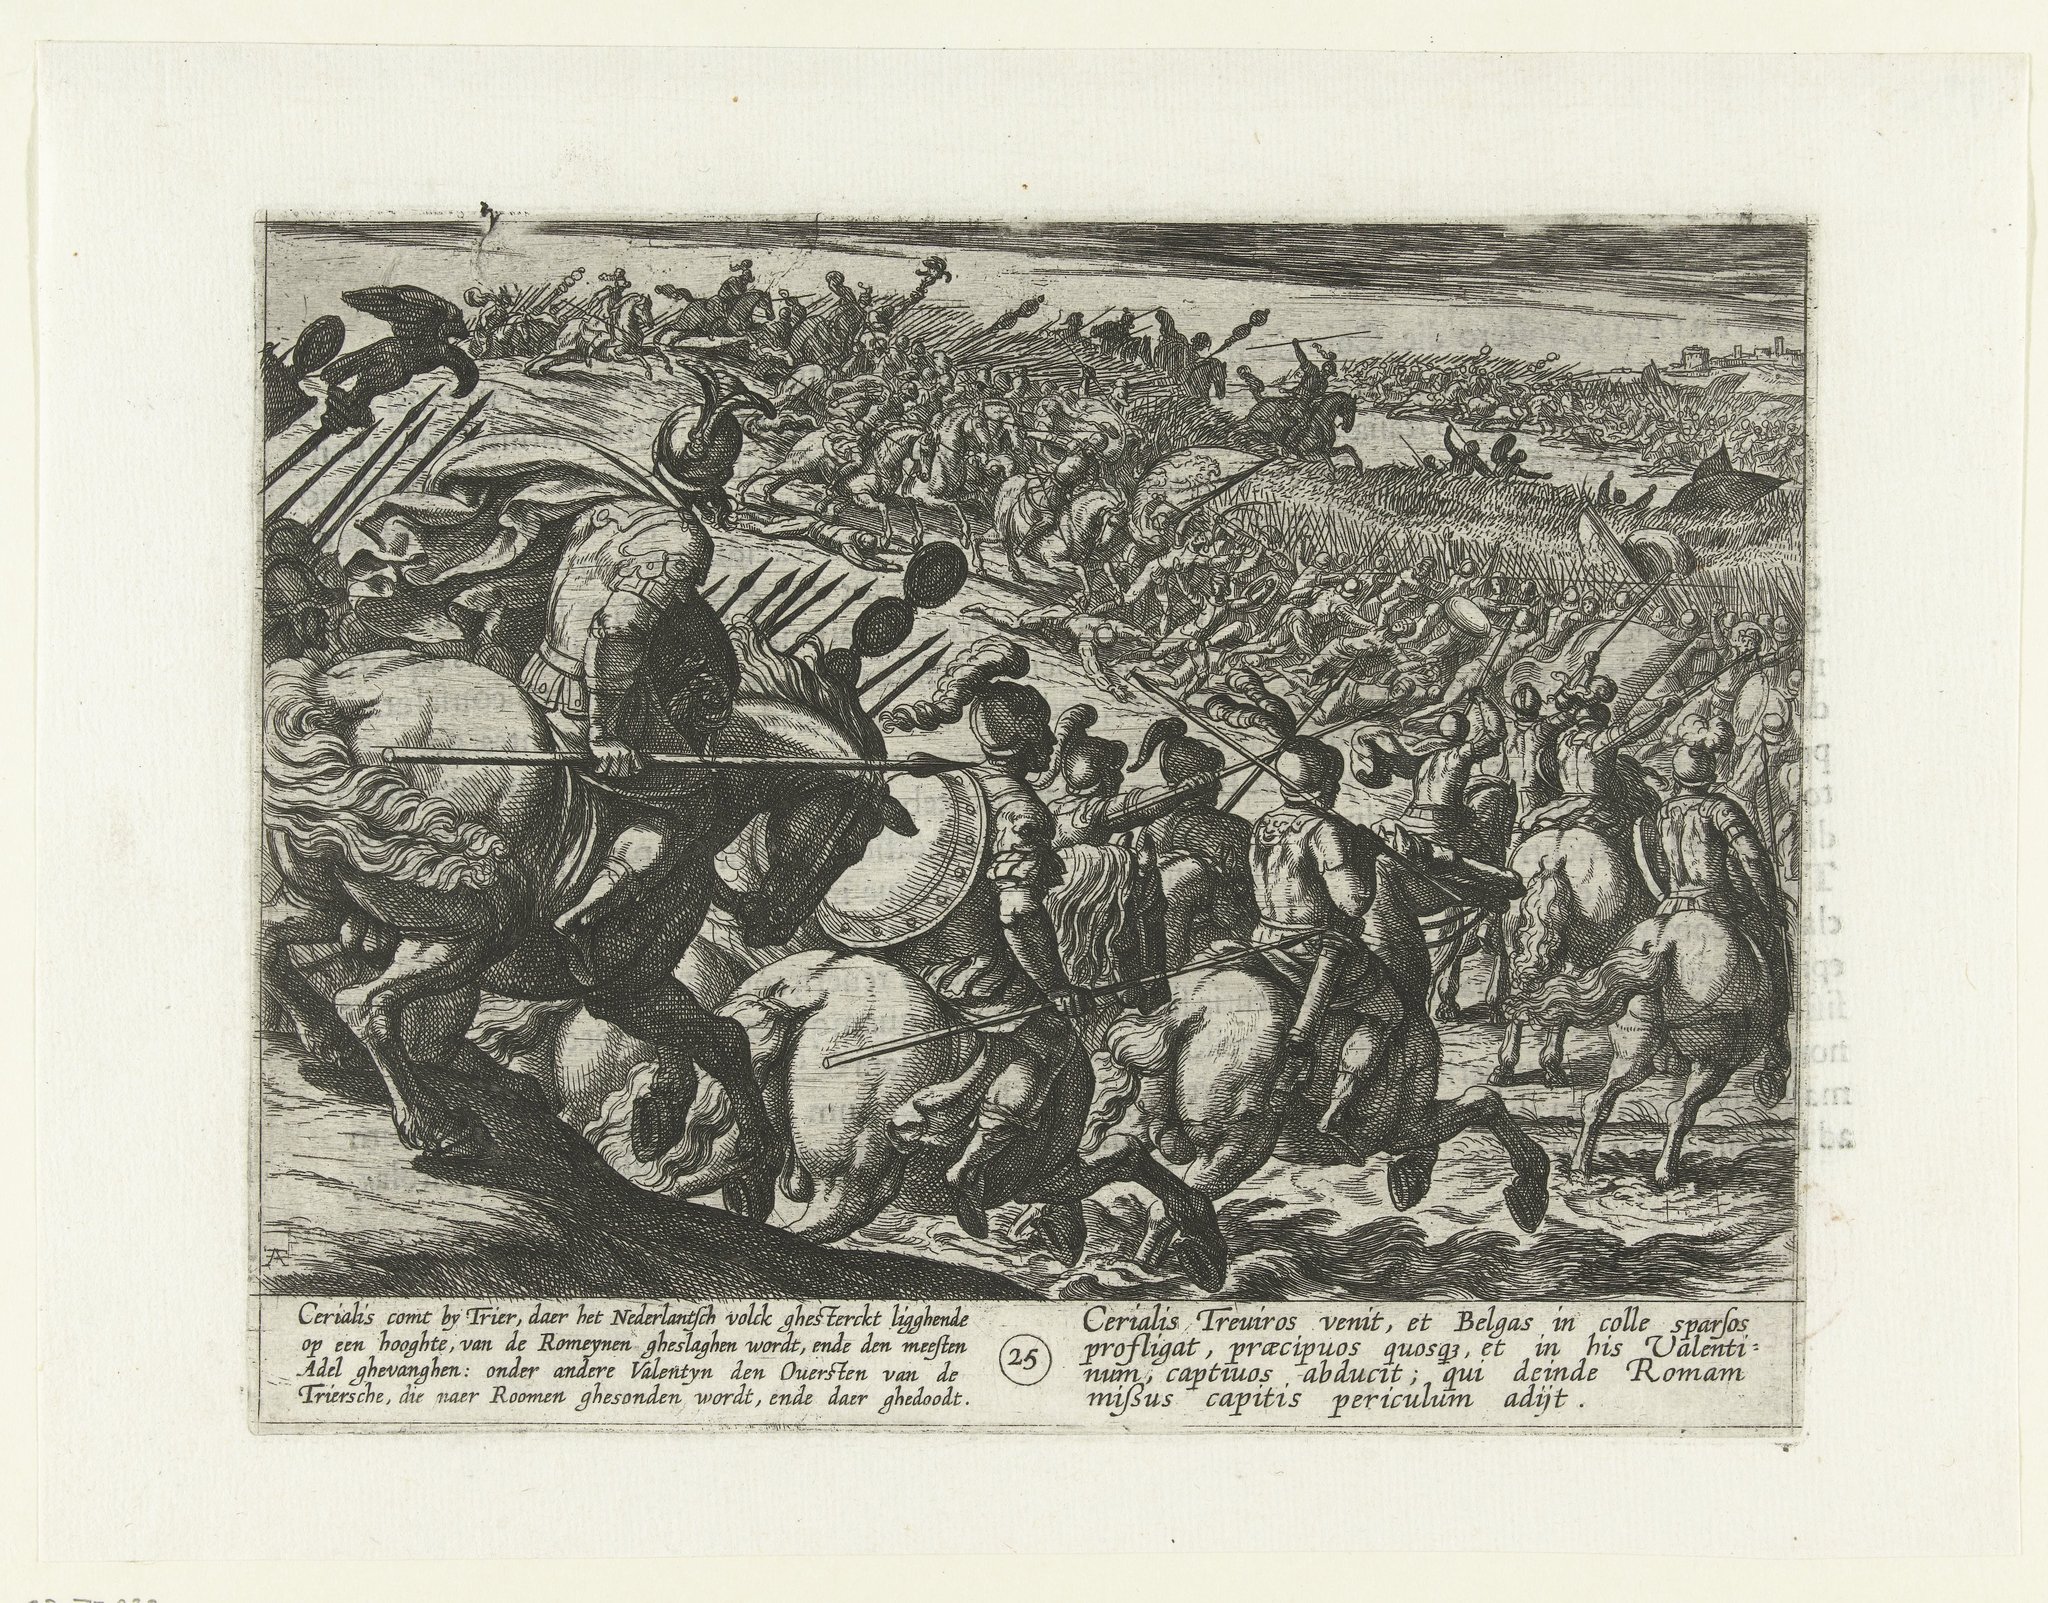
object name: history print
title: Batavorum cum Romanis Bellum, à Corn. Tacito / De Batavische Oft Oude Hollandtsche Oorloghe teghen de Romeynen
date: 1612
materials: paper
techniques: etching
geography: italy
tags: battle, fighting in general, extinct, 'historical' peoples (with name)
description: De Bataven worden bij Trier verslagen door Cerialis. Prent nummer 25 in de serie prenten over de Bataafse Opstand: Batavorum cum Romanis bellum / à Corn. Tacito lib. IV & V. : Hist. olim descriptum, figuris nunc aeneis expressum, auctore Othone Vaenio Lugdunobatava = De Batavische oft oude Hollandtsche oorloghe teghen de Romeynen. Otto Vaenius, Antwerpen 1612. Onderaan twee verzen van vier regels in het Nederlands en in het Latijn. Op de achterzijde tekst in het Latijn.